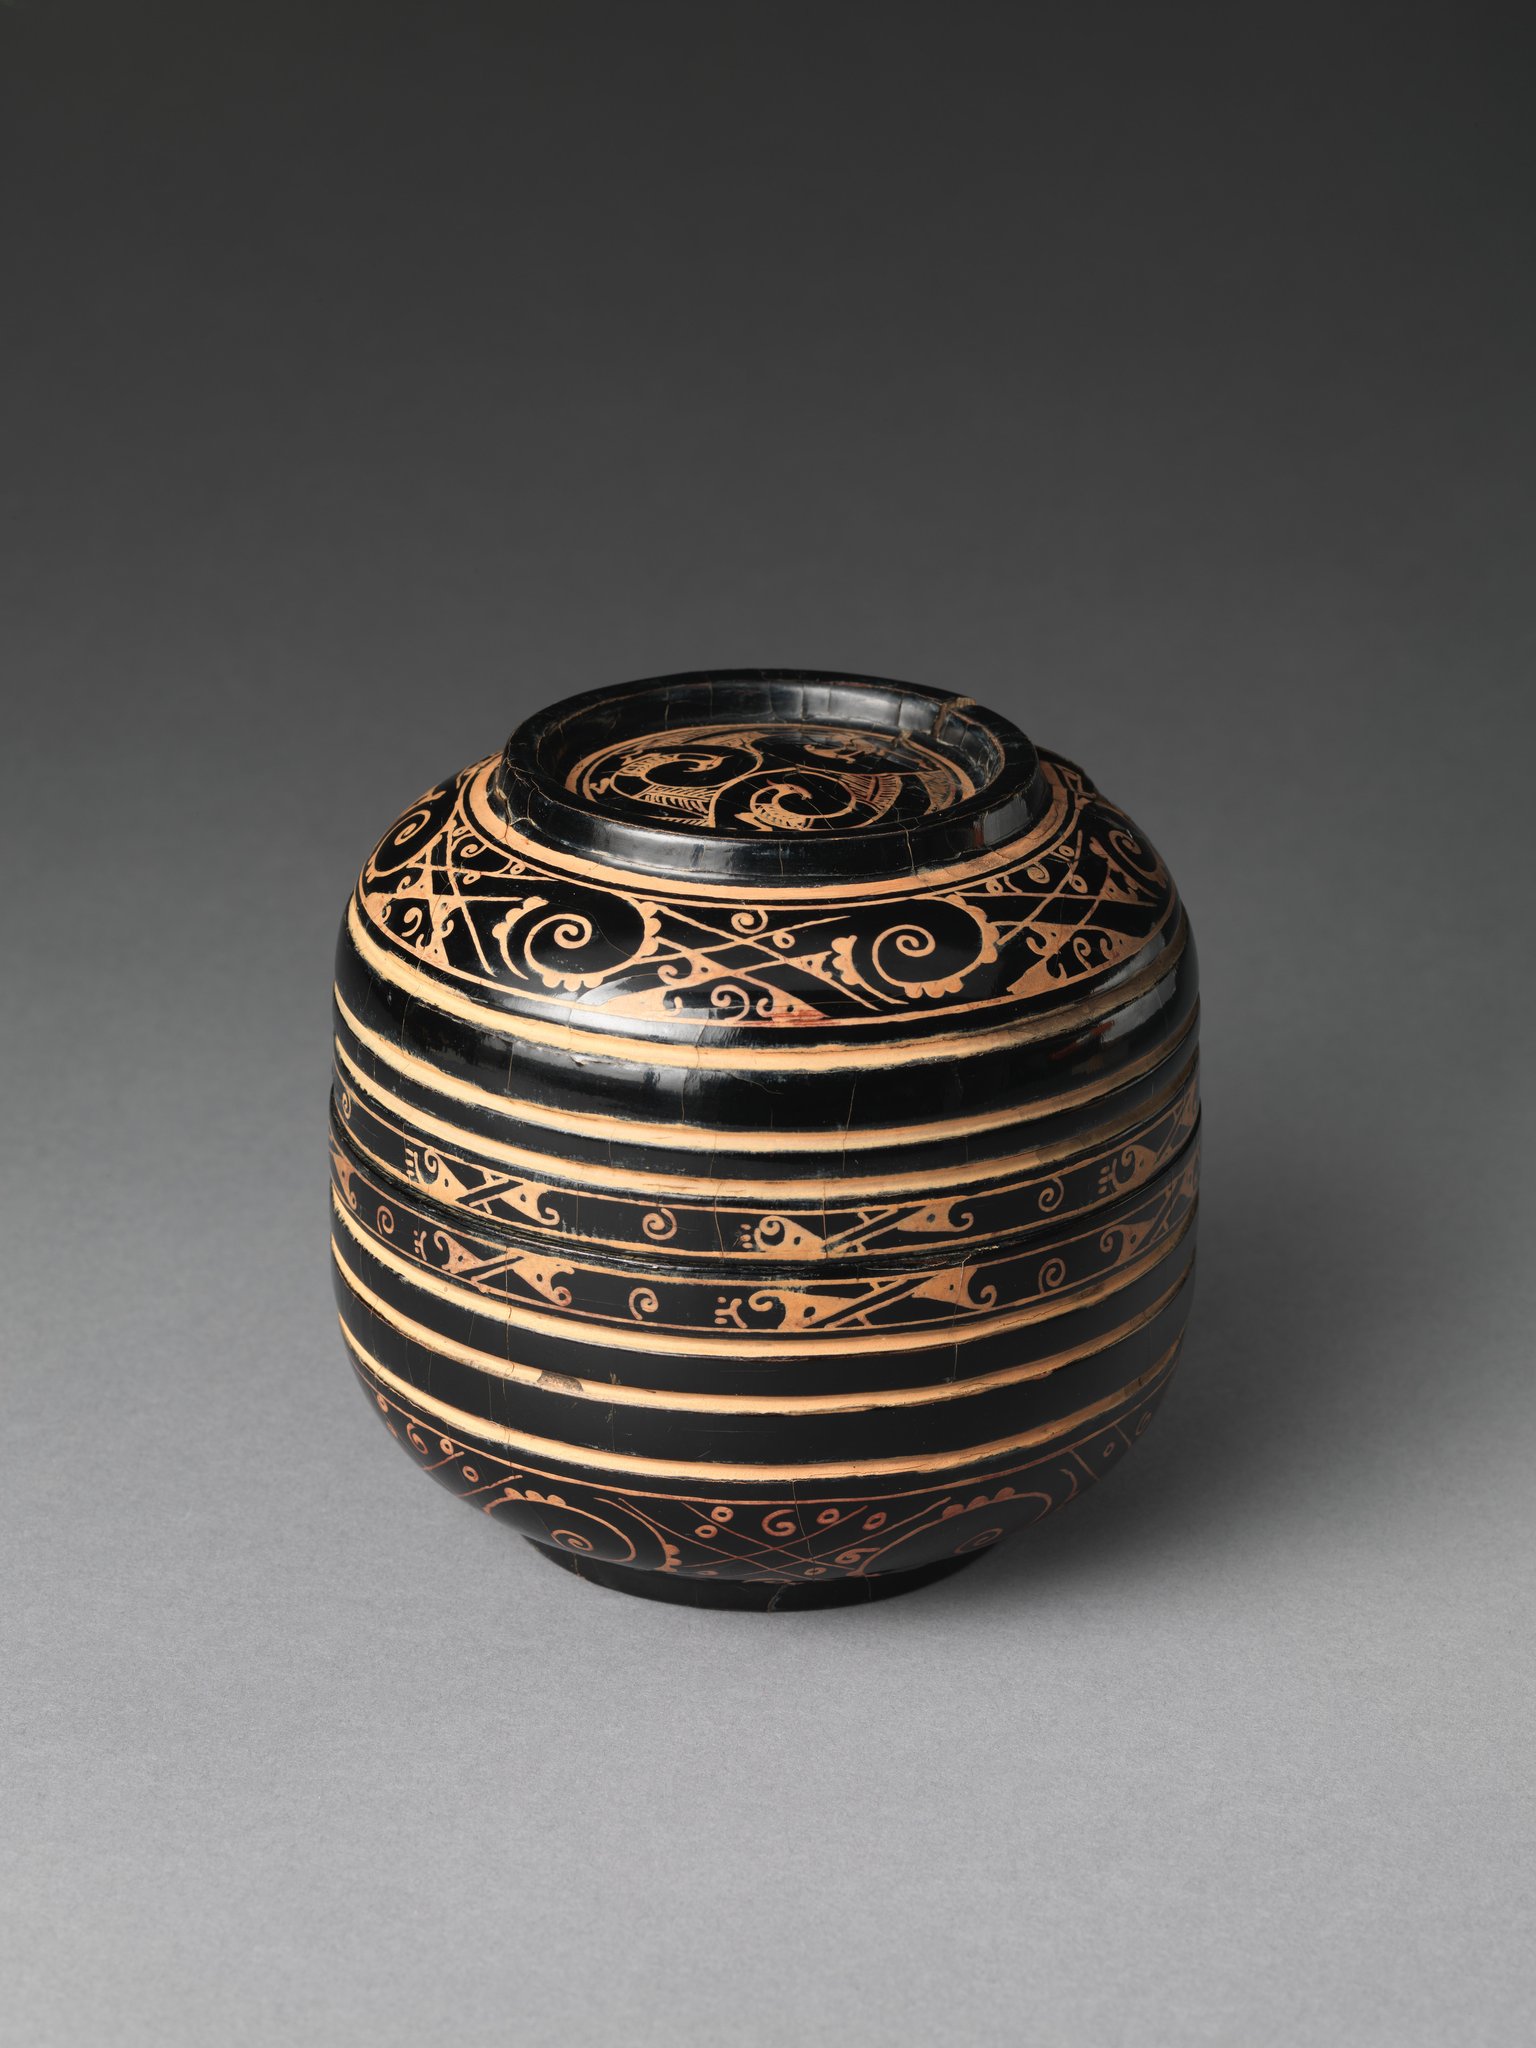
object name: box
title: Round Box and Cover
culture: chinese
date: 101-300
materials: lacquer